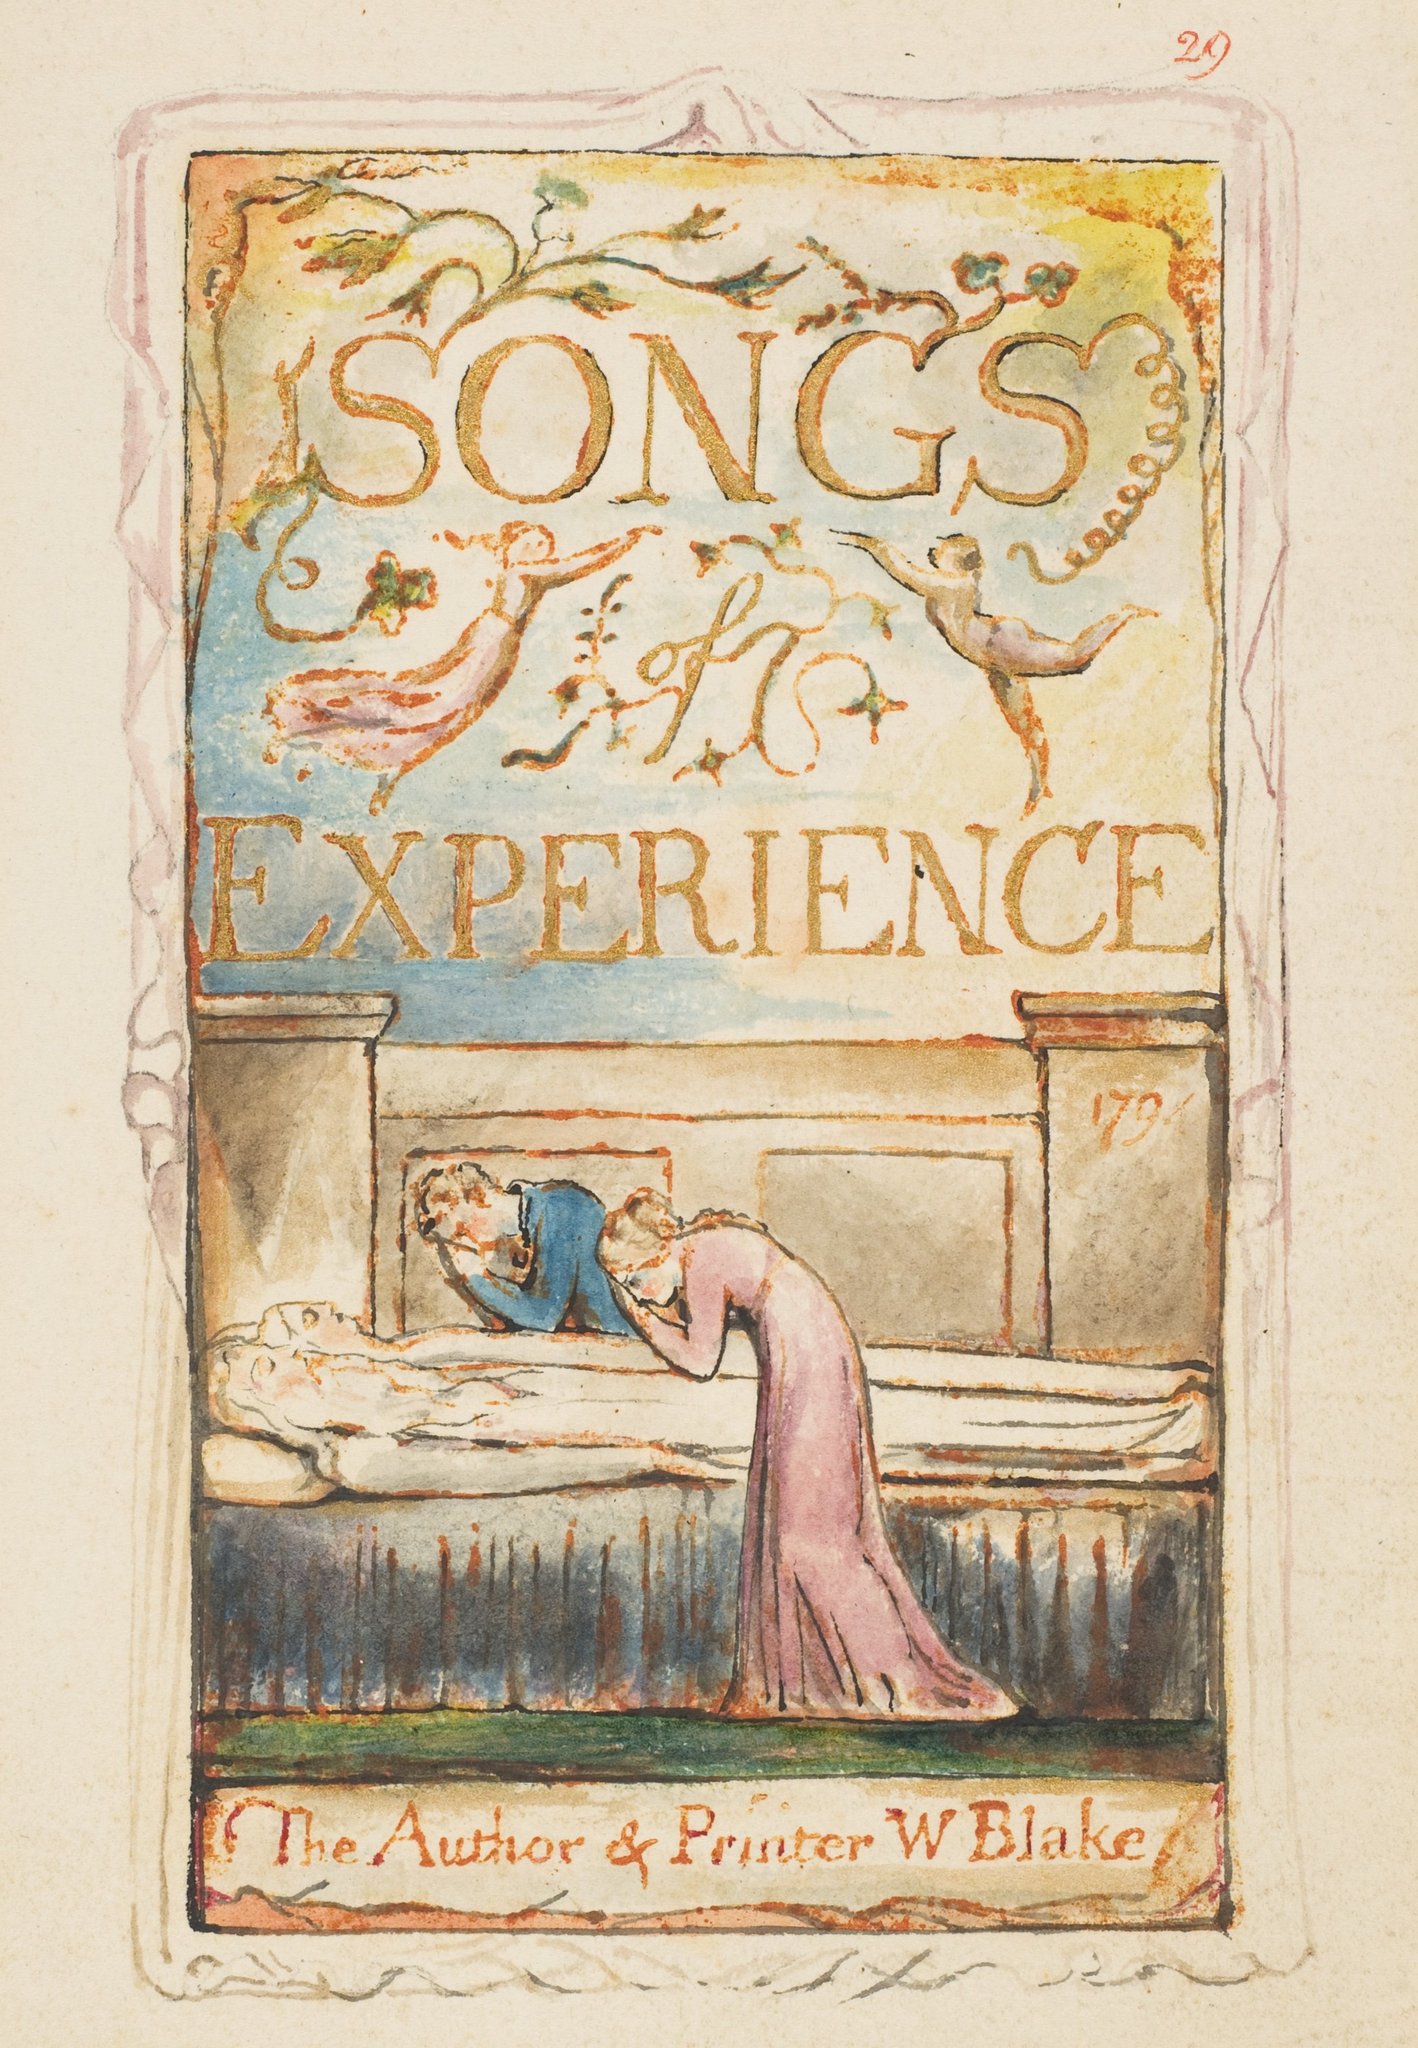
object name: print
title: Songs of Experience: Title-page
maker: william blake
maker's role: artist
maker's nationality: british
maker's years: 1757-1827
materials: gold, ink, shell, watercolor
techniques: etching, hand coloring, printing, relief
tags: poetry,men,women